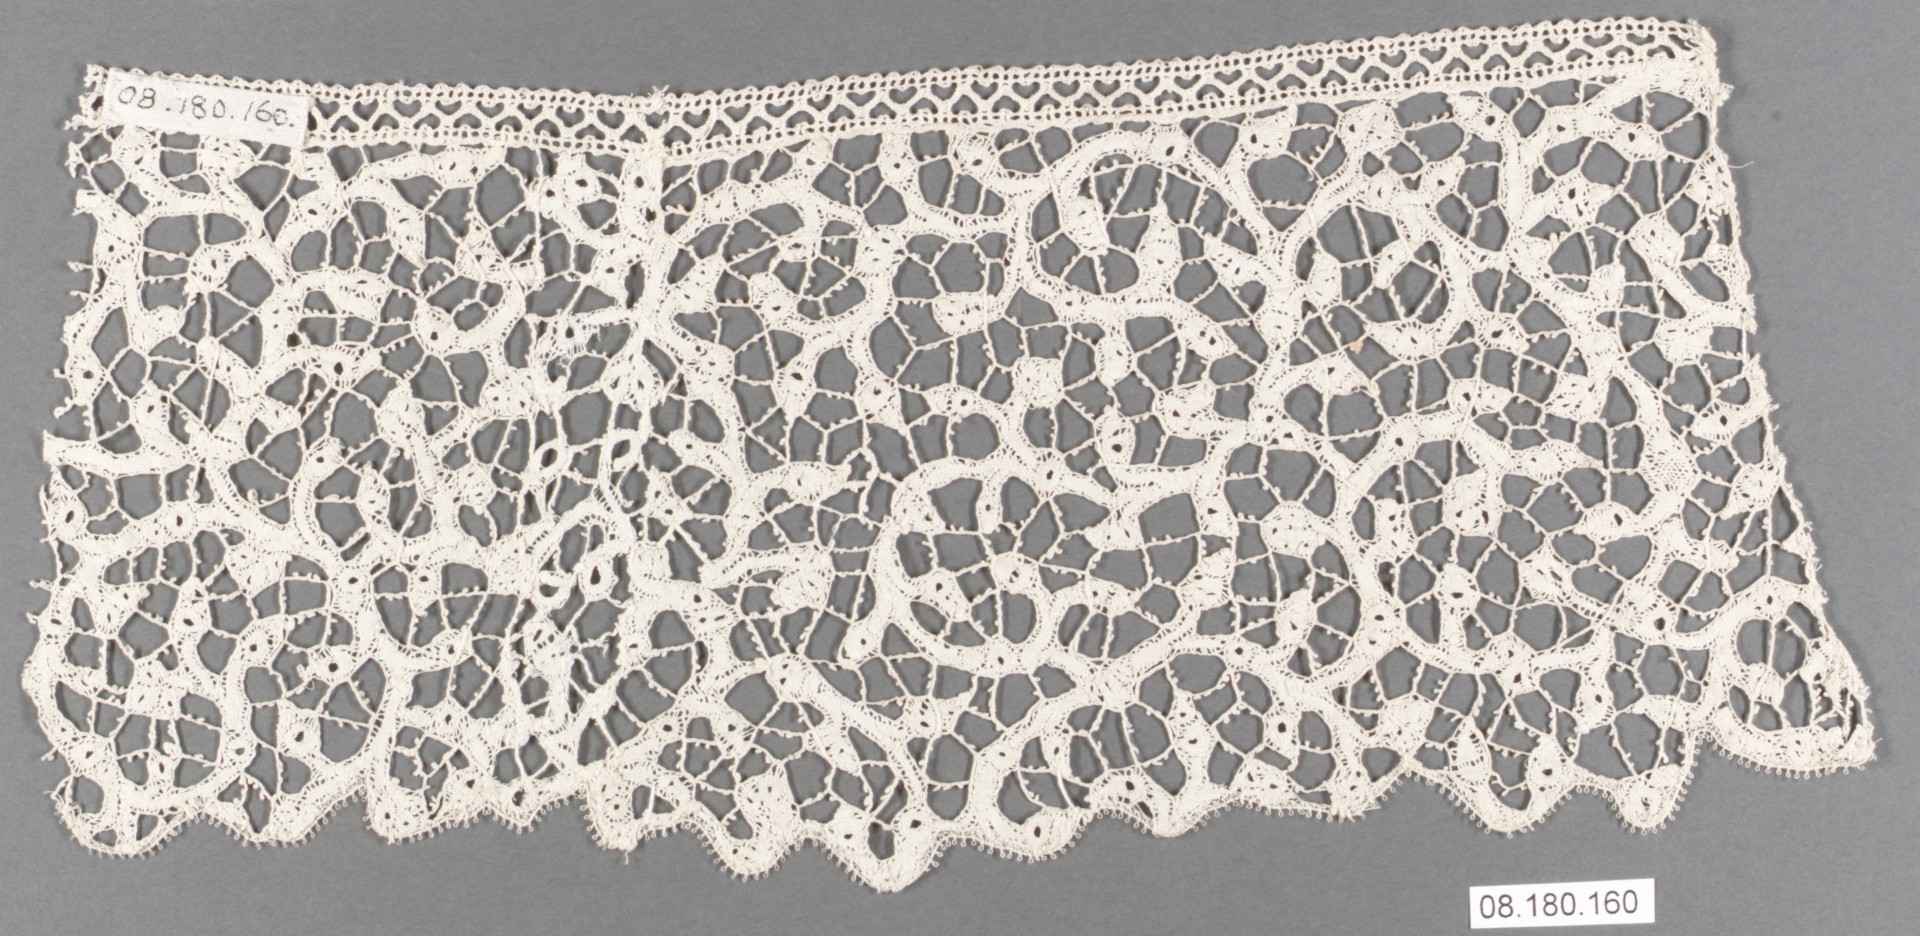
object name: fragment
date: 1701-1800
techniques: lace